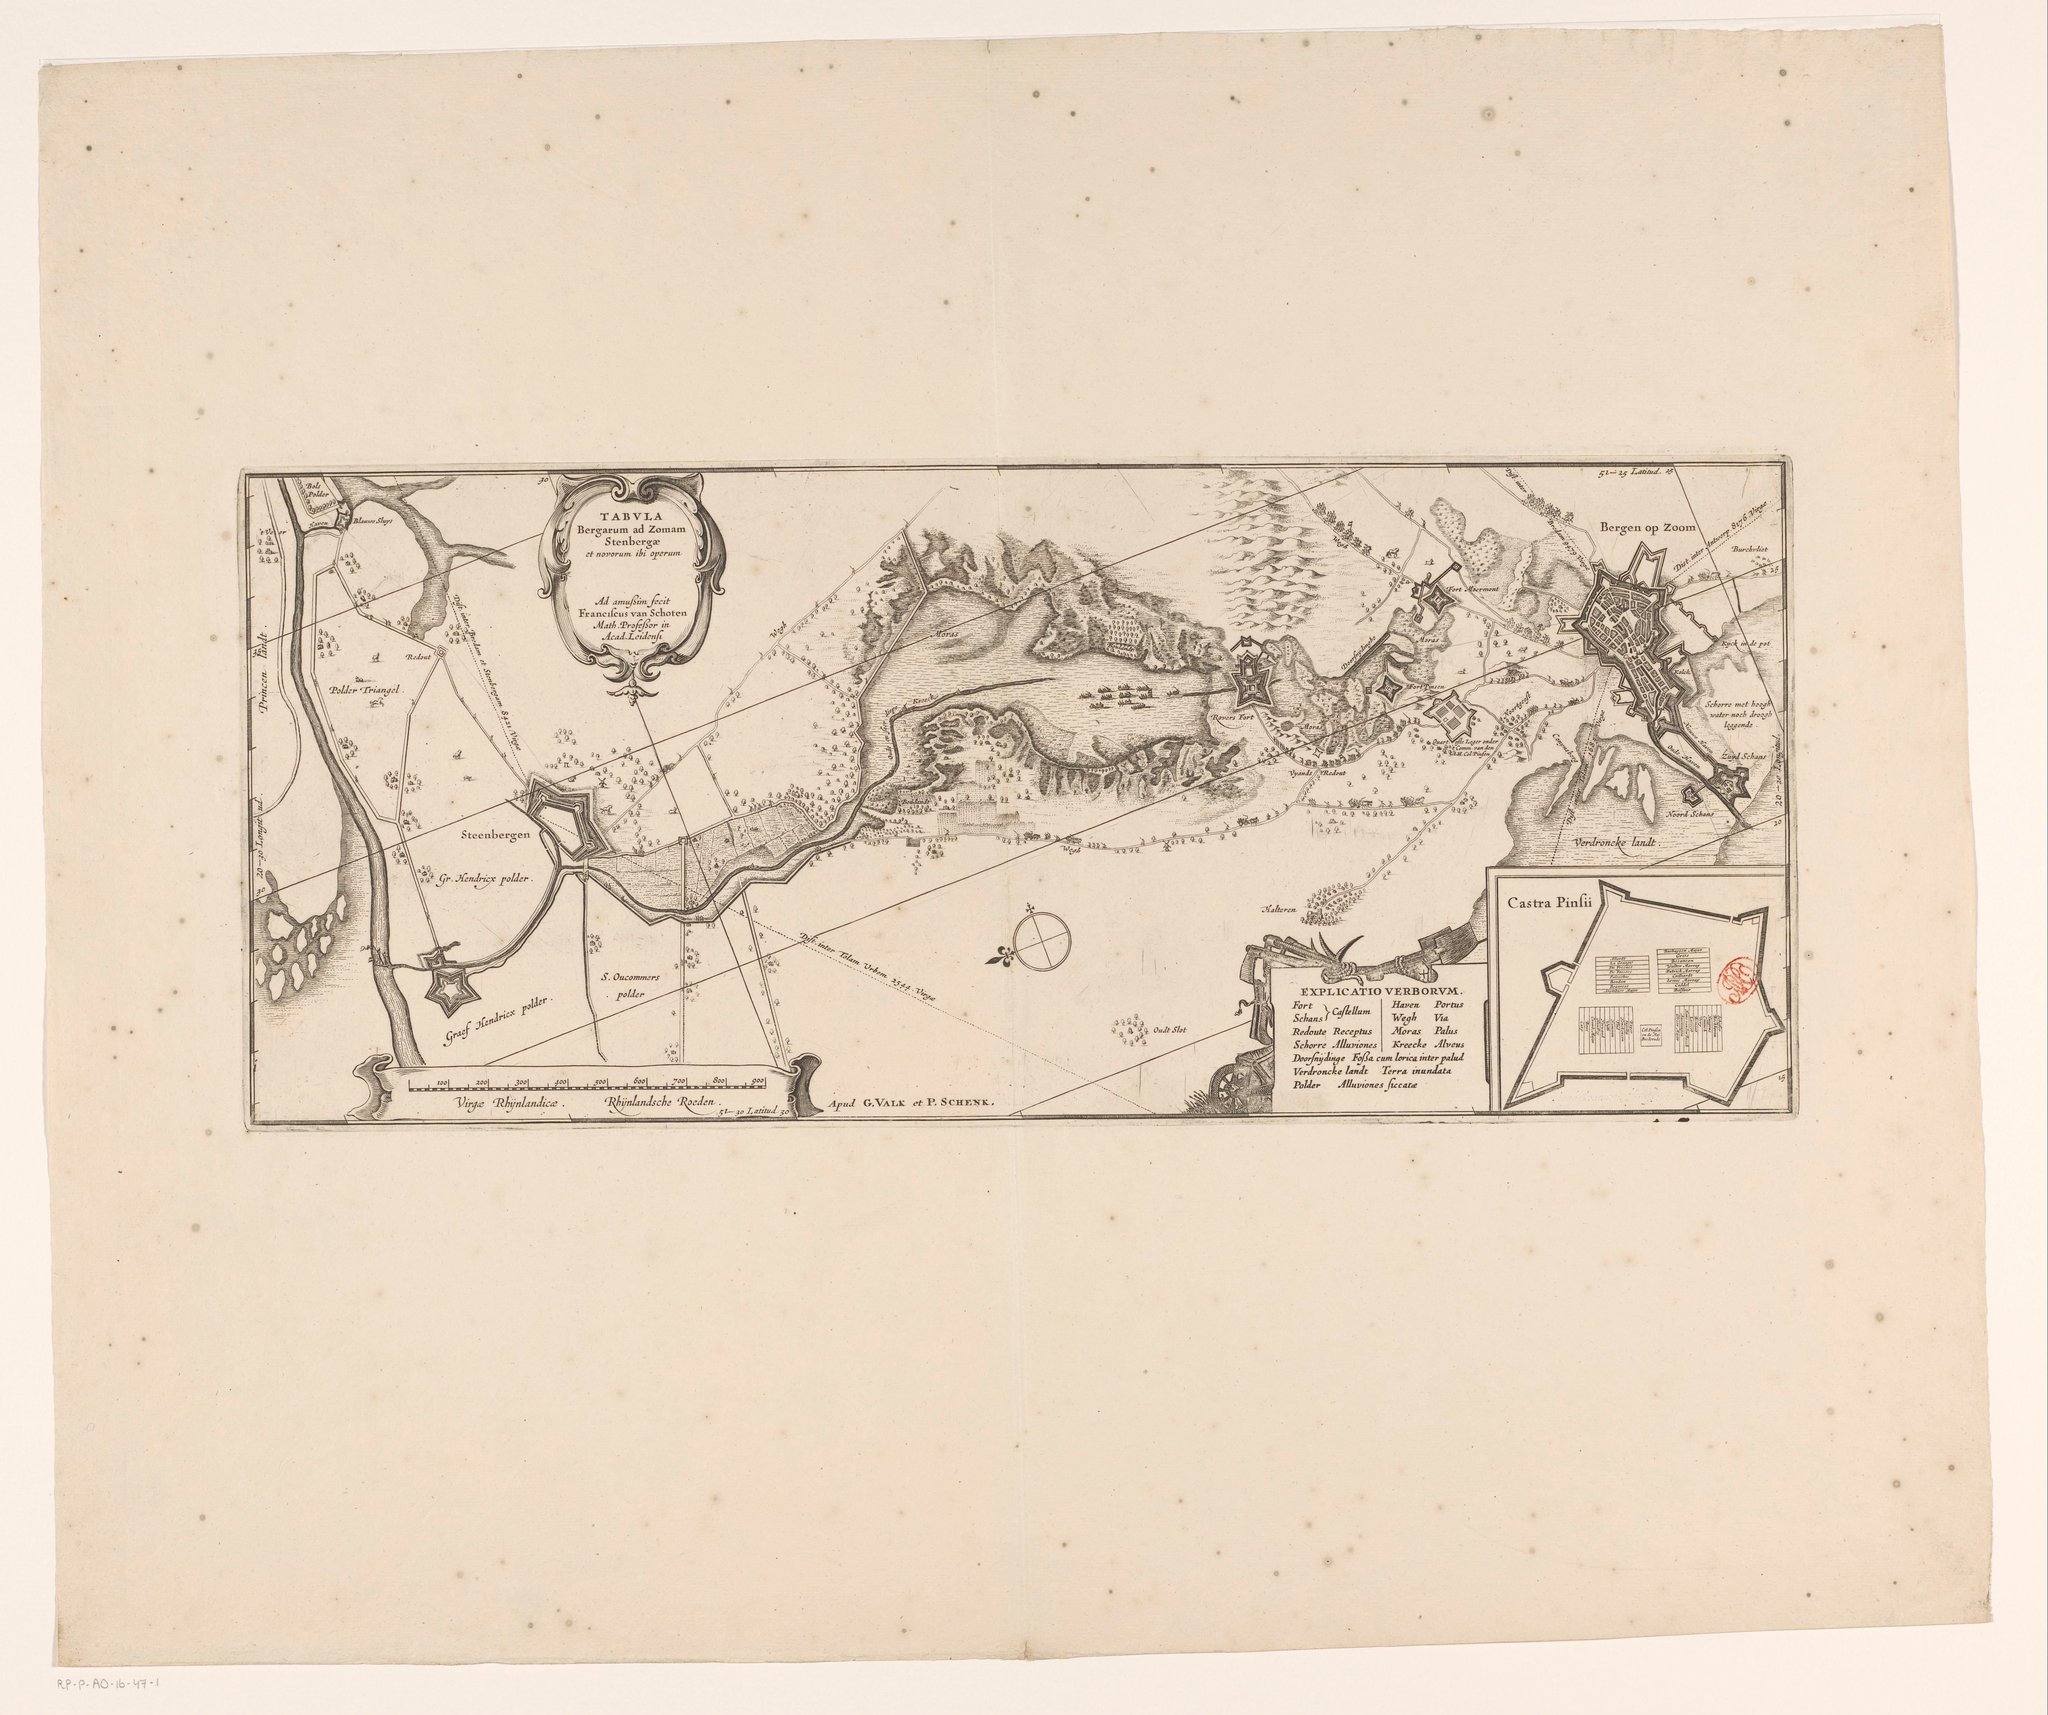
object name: print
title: Tabula Bergarum ad Zomam Stenbergae et novorum ibi operum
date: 1636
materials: paper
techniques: engraving, etching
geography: leiden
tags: maps of separate countries or regions, bergen op zoom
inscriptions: collector's mark: Lugt 195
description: Kaart van het mislukte beleg van Bergen op Zoom door het Spaanse leger onder Spinola en Velasco, 18 juli - 3 oktober 1622. Kaart van Bergen op Zoom met het gebied tot Steenbergen. Linksboven een cartouche met Latijnse titel. Rechtsonder een inzet met de plattegrond van het Fort Pinsen (Castra Pinsii). Links van de inzet een woordenverklaring Nederlands-Latijn. Linksonder een schaalstok: 900 Virgae Rhijnlandicae / 900 Rhijnlandsche Roeden. De kaart is voorzien van een coördinaten-net en gradenverdeling.